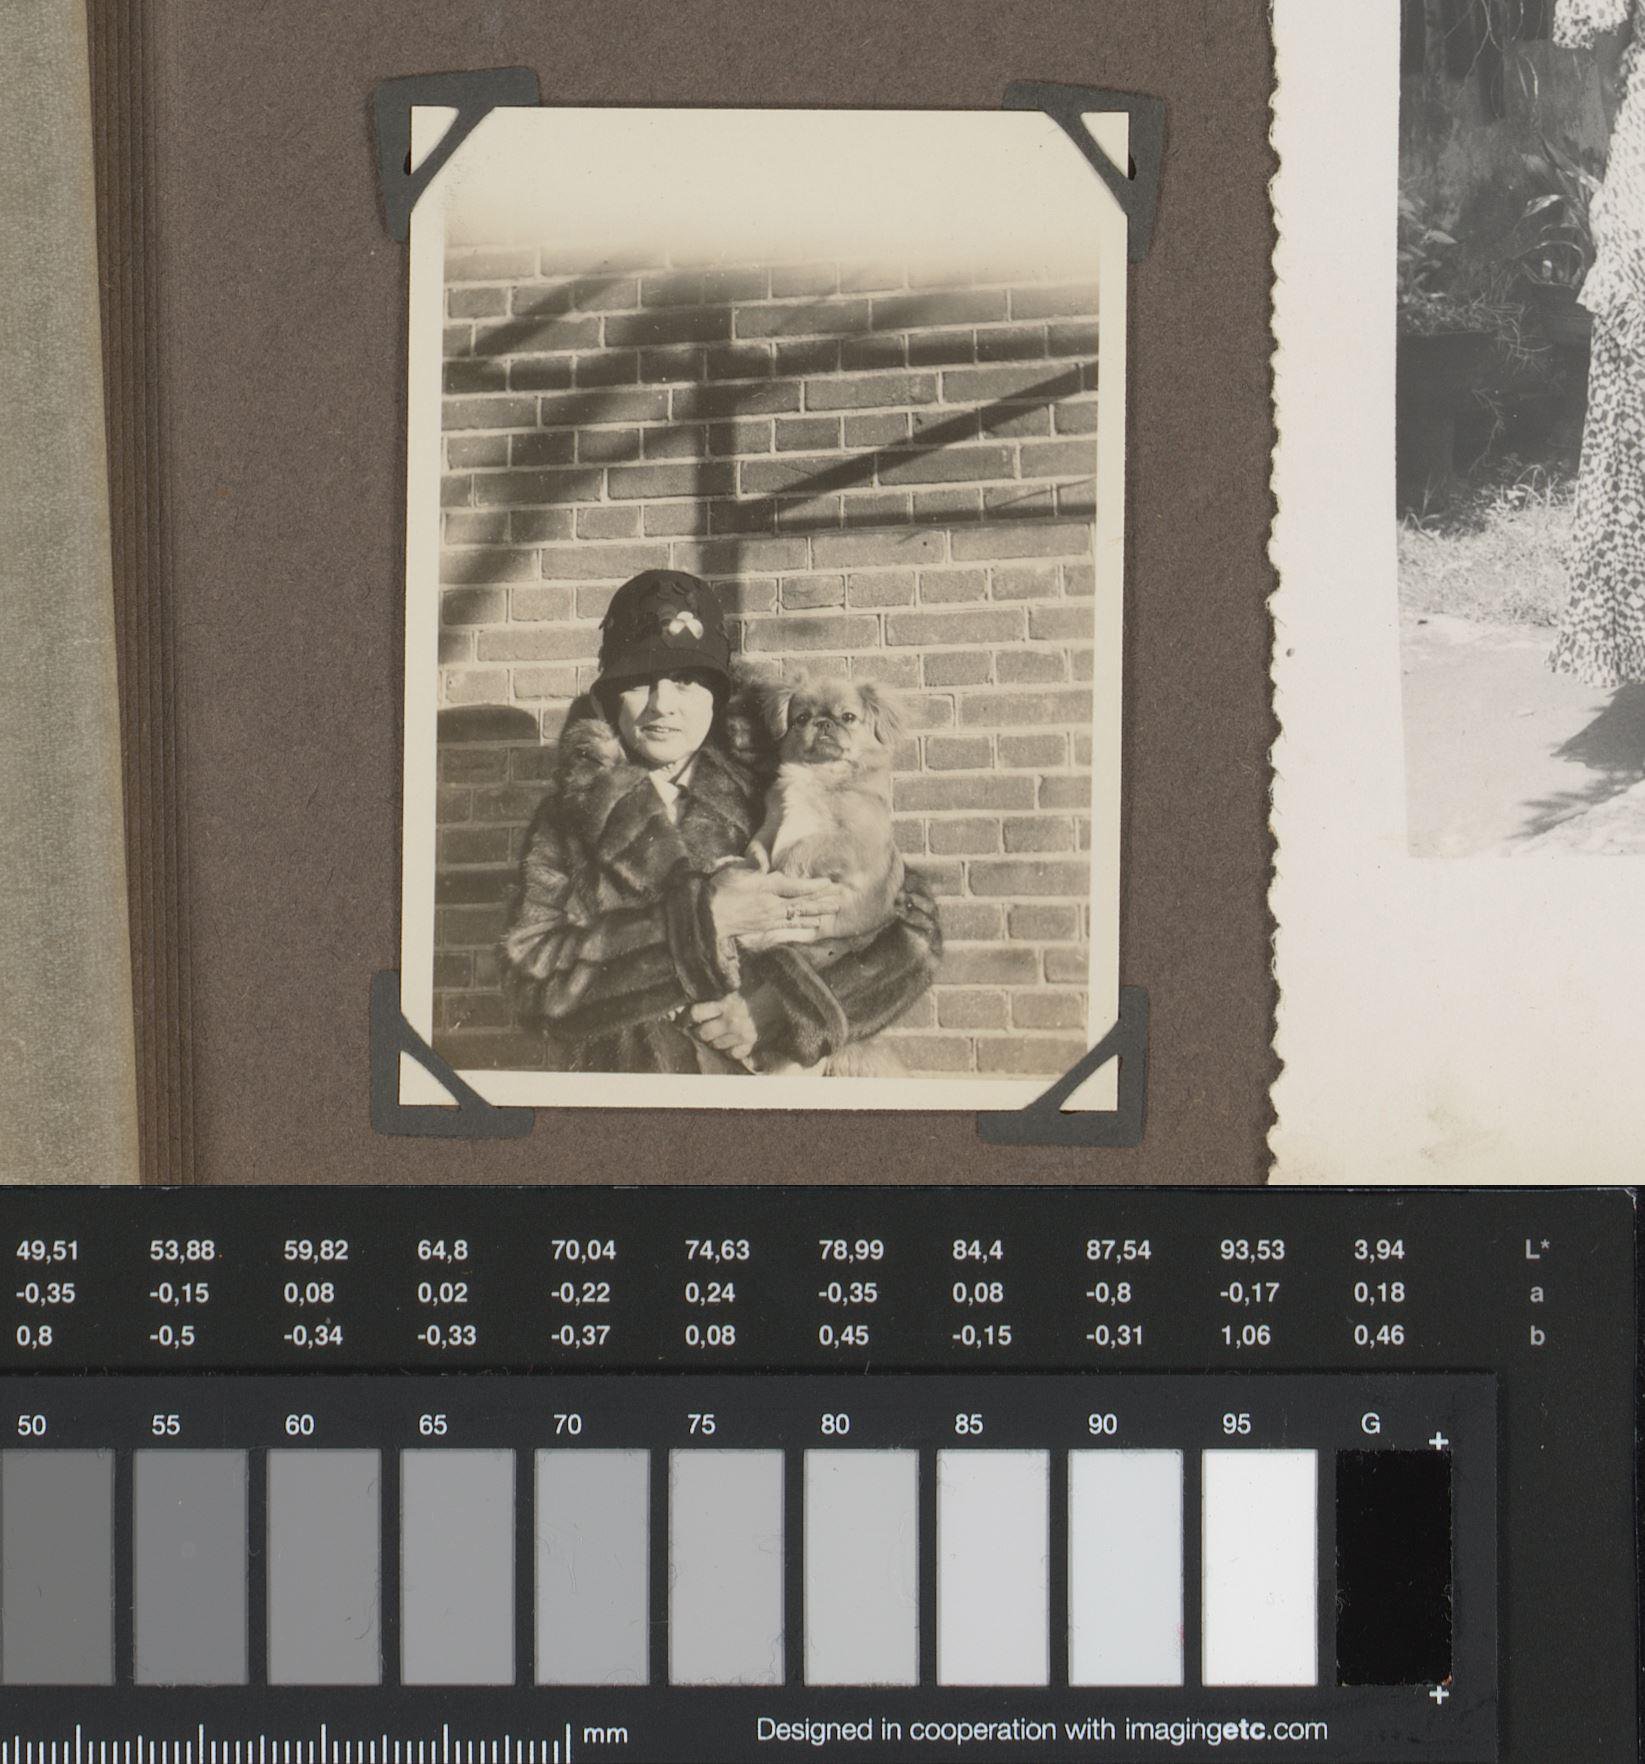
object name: photograph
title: Portret van Henriëtte Wassink met een hond voor een muur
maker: Anonymous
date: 1930-1935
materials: paper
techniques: gelatin silver print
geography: netherlands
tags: batavia, the hague, henriëtte wassink, adult woman, historical persons, dog, netherlands